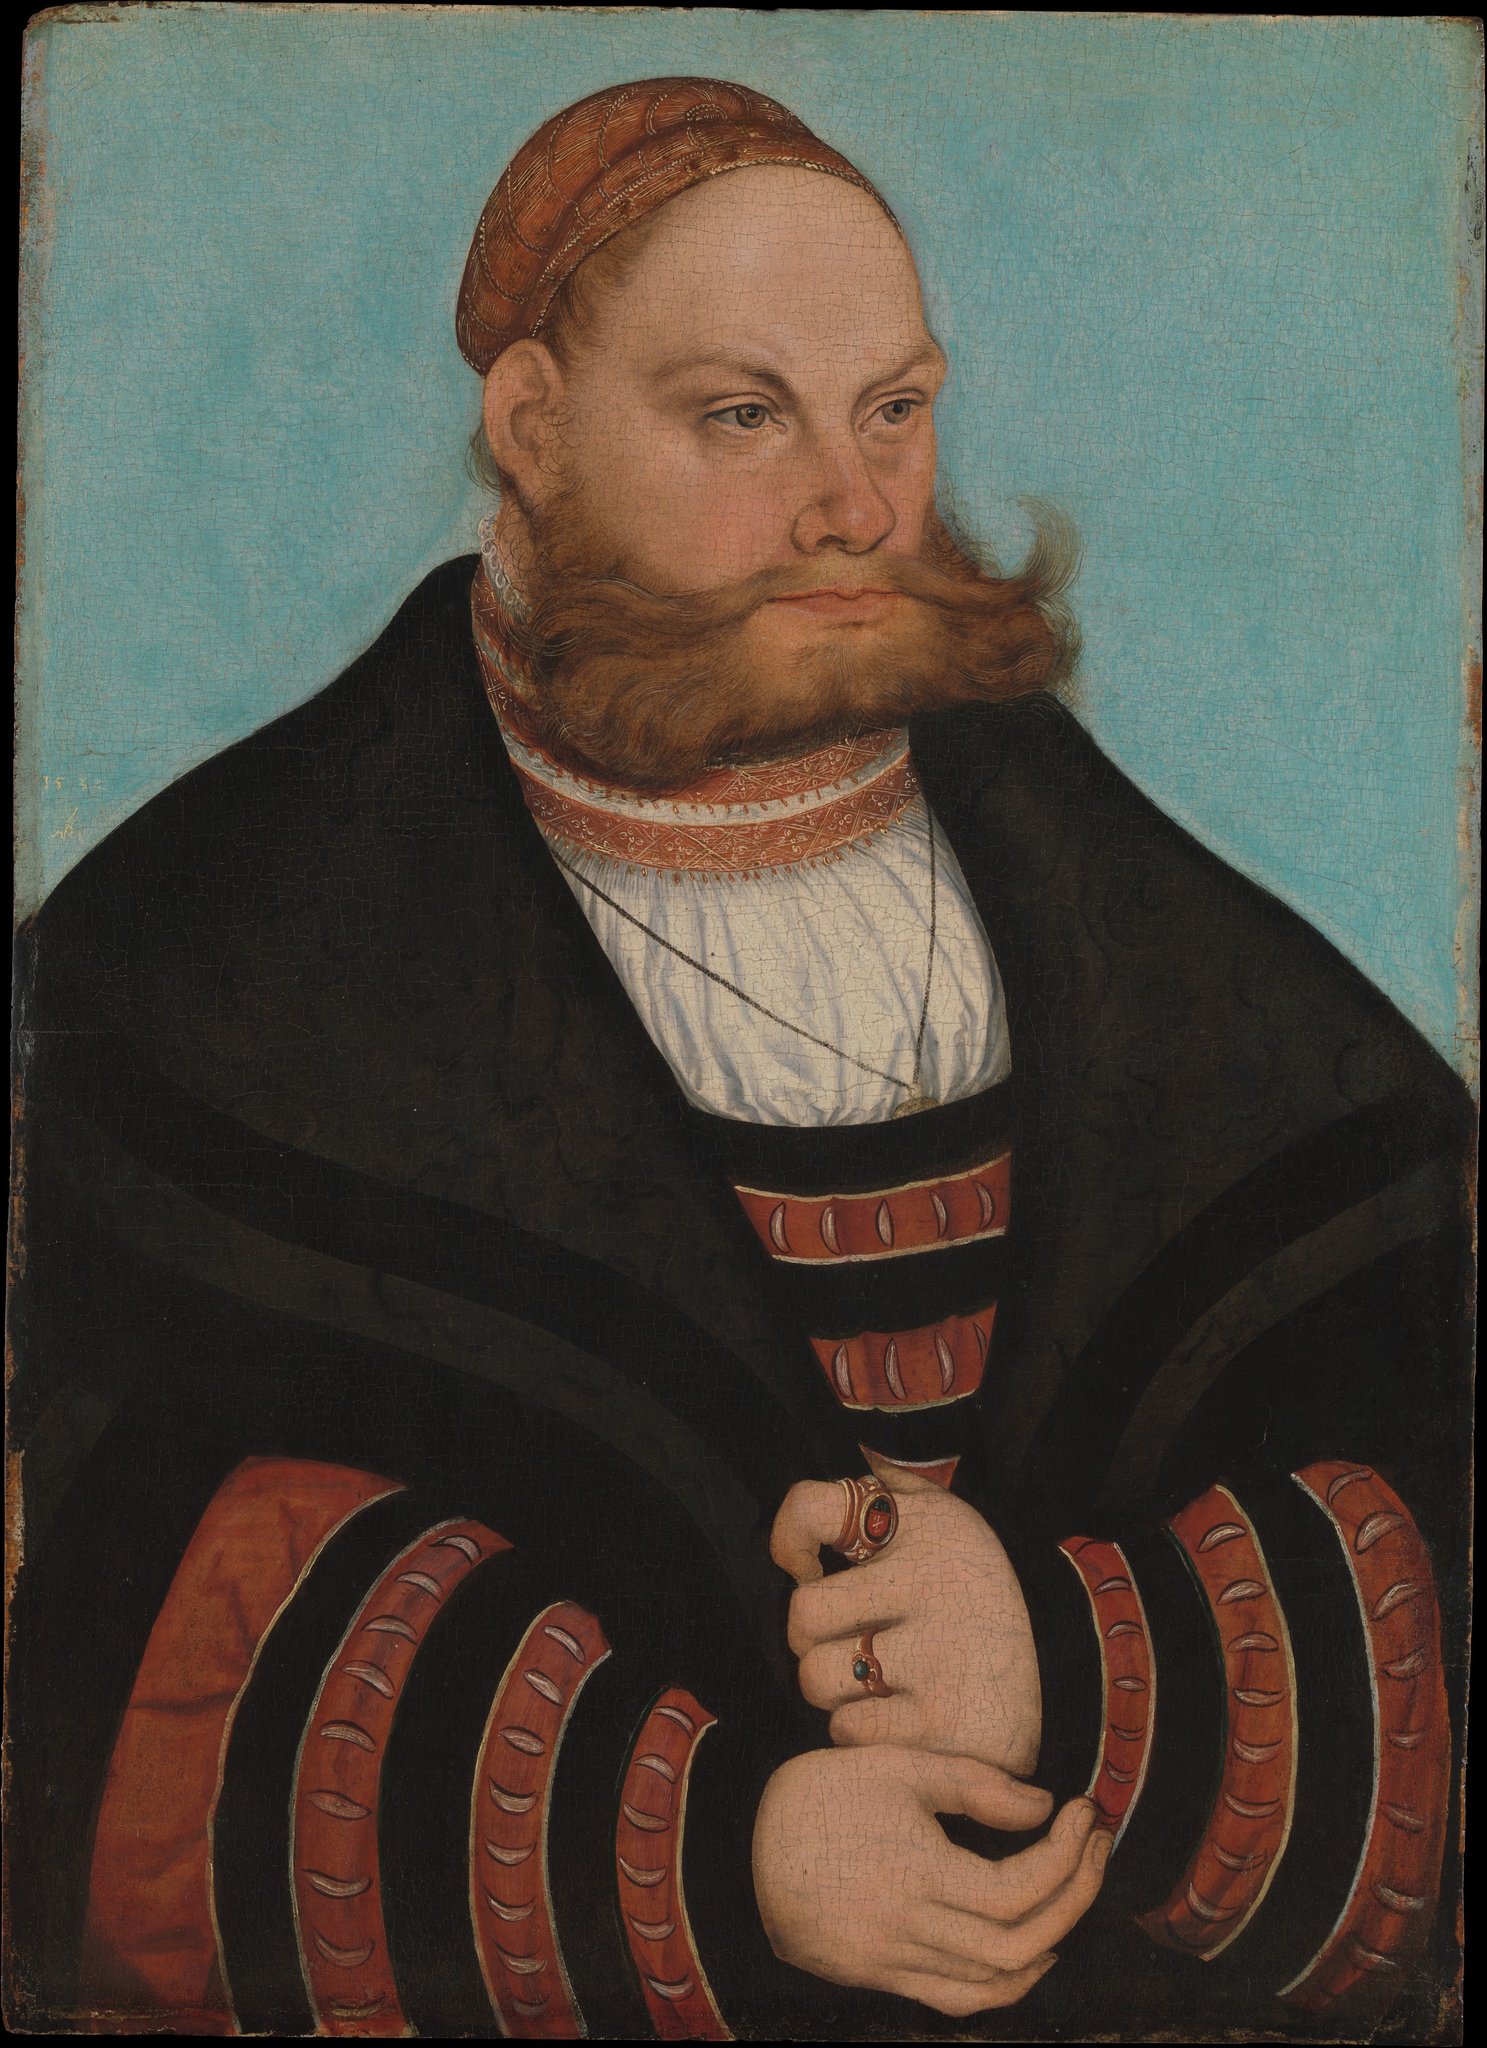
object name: painting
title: Lukas Spielhausen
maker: lucas cranach the elder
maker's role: artist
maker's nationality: german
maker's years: 1472-1553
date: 1532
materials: wood, gold, oil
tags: men,portraits